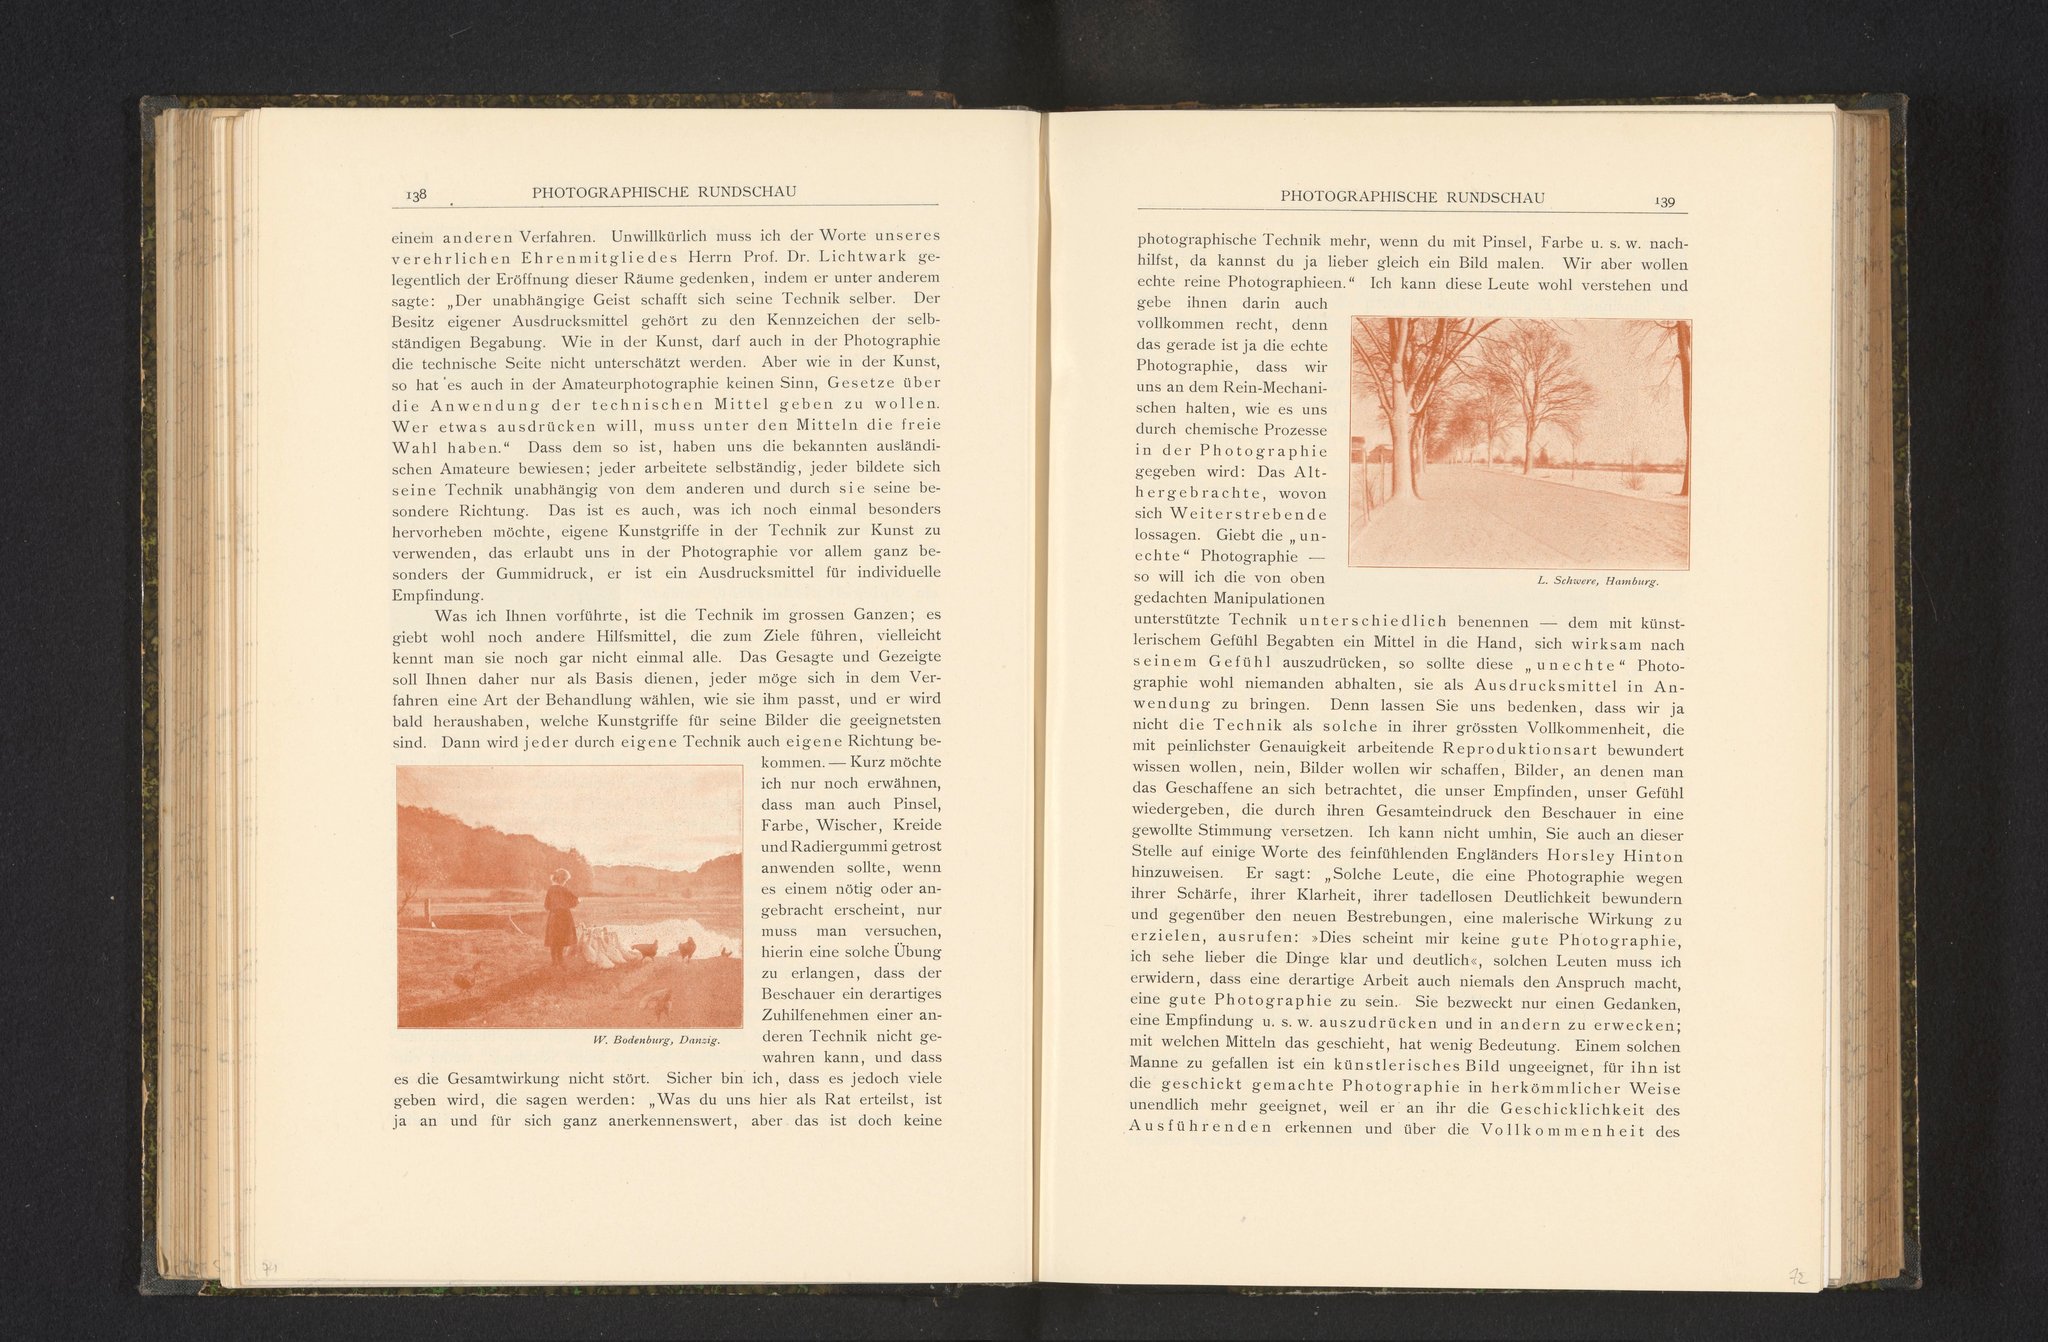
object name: photomechanical print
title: Meisje voert ganzen en kippen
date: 1893-1898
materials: paper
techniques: autotype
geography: danzig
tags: poultry farm, girl (child between toddler and youth), feeding wild animals